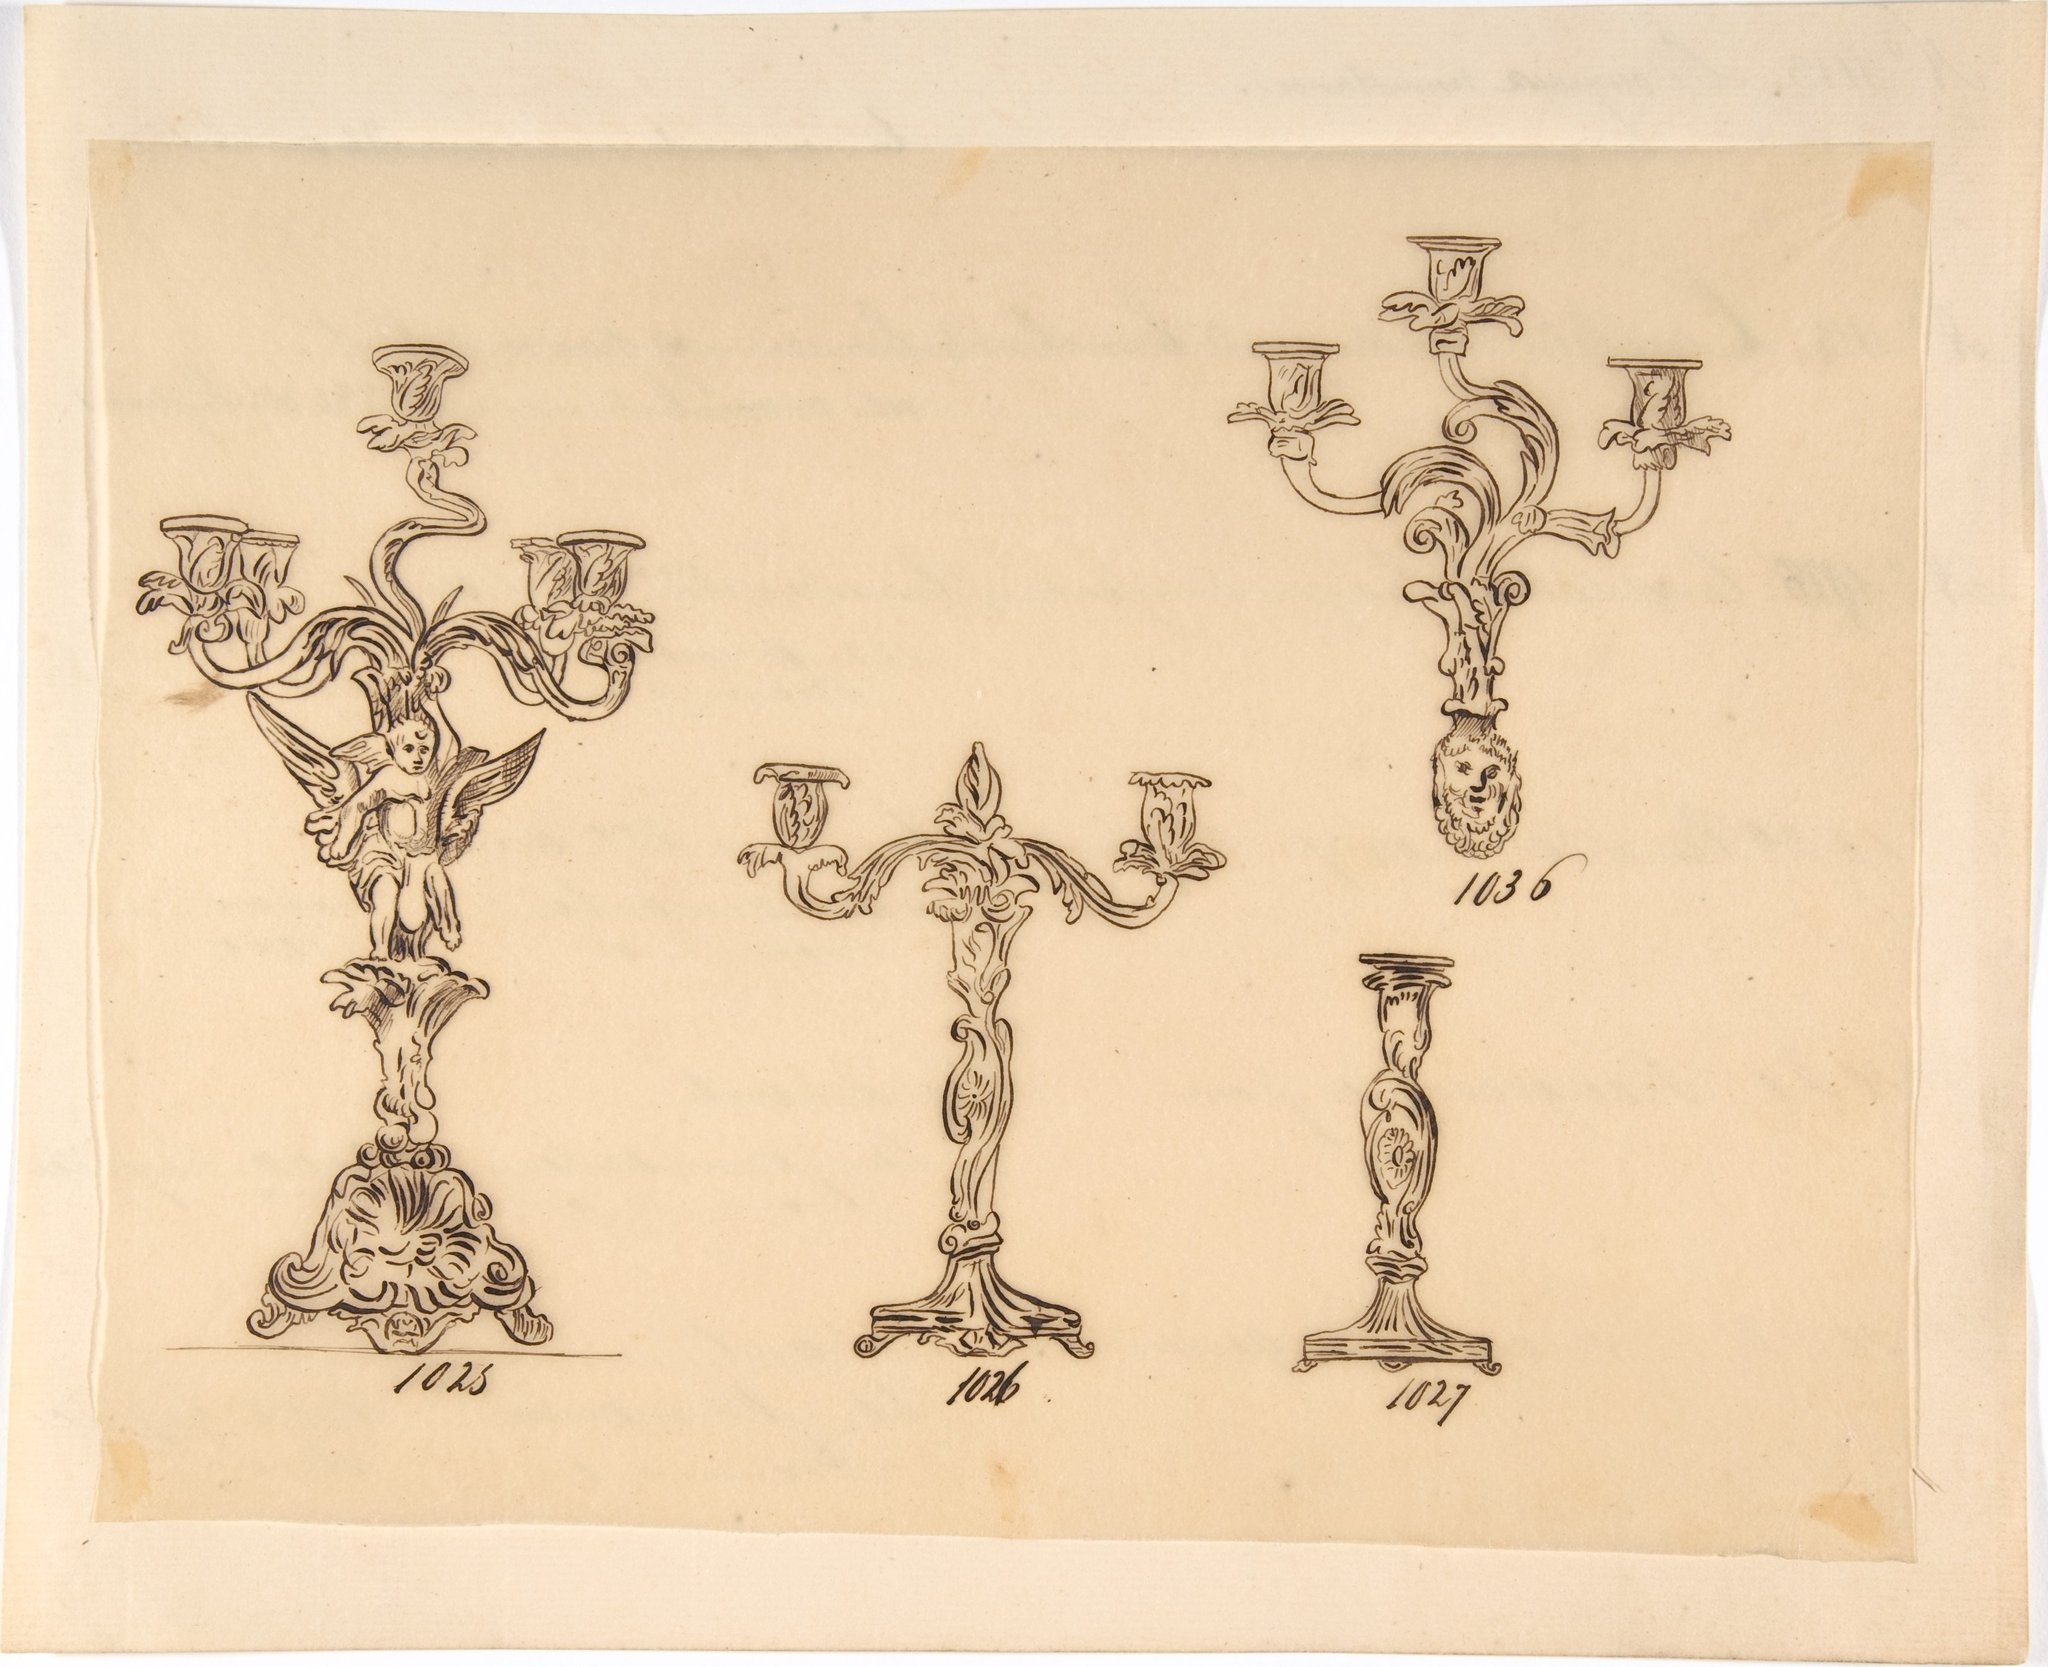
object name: drawing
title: Designs for Four Candle Fixtures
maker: anonymous, french, 19th century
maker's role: artist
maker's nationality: french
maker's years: 1800-1900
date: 1801-1900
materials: ink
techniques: pen